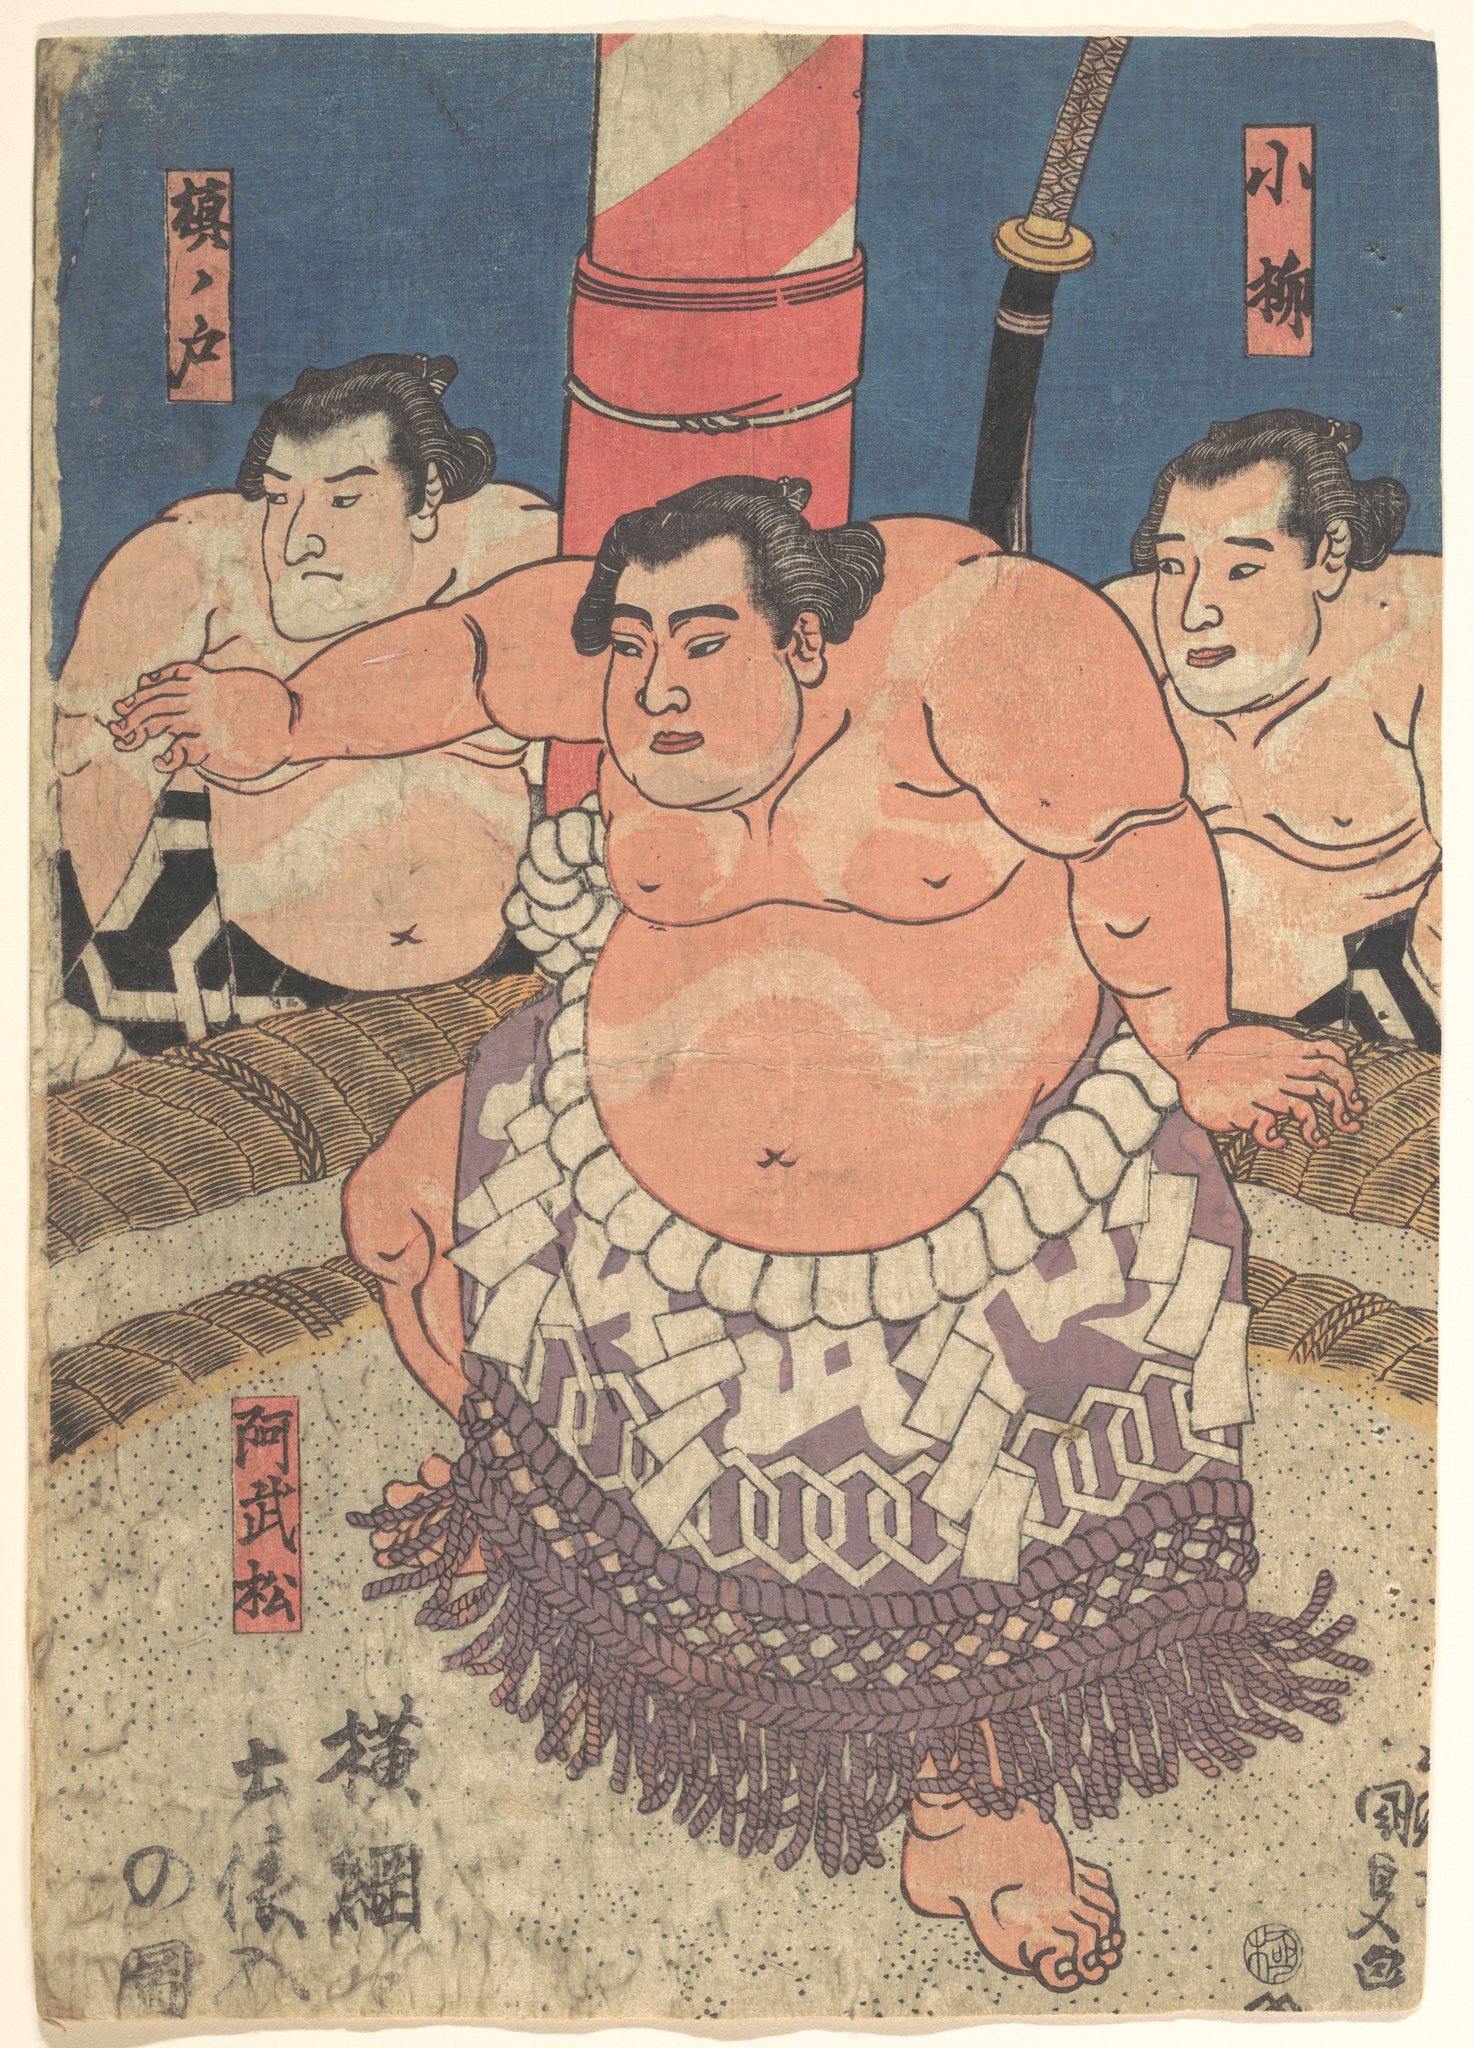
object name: print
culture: japanese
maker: utagawa kunisada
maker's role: artist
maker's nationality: japanese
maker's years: 1786-1864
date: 1801-1900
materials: ink, paper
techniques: woodblock print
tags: men